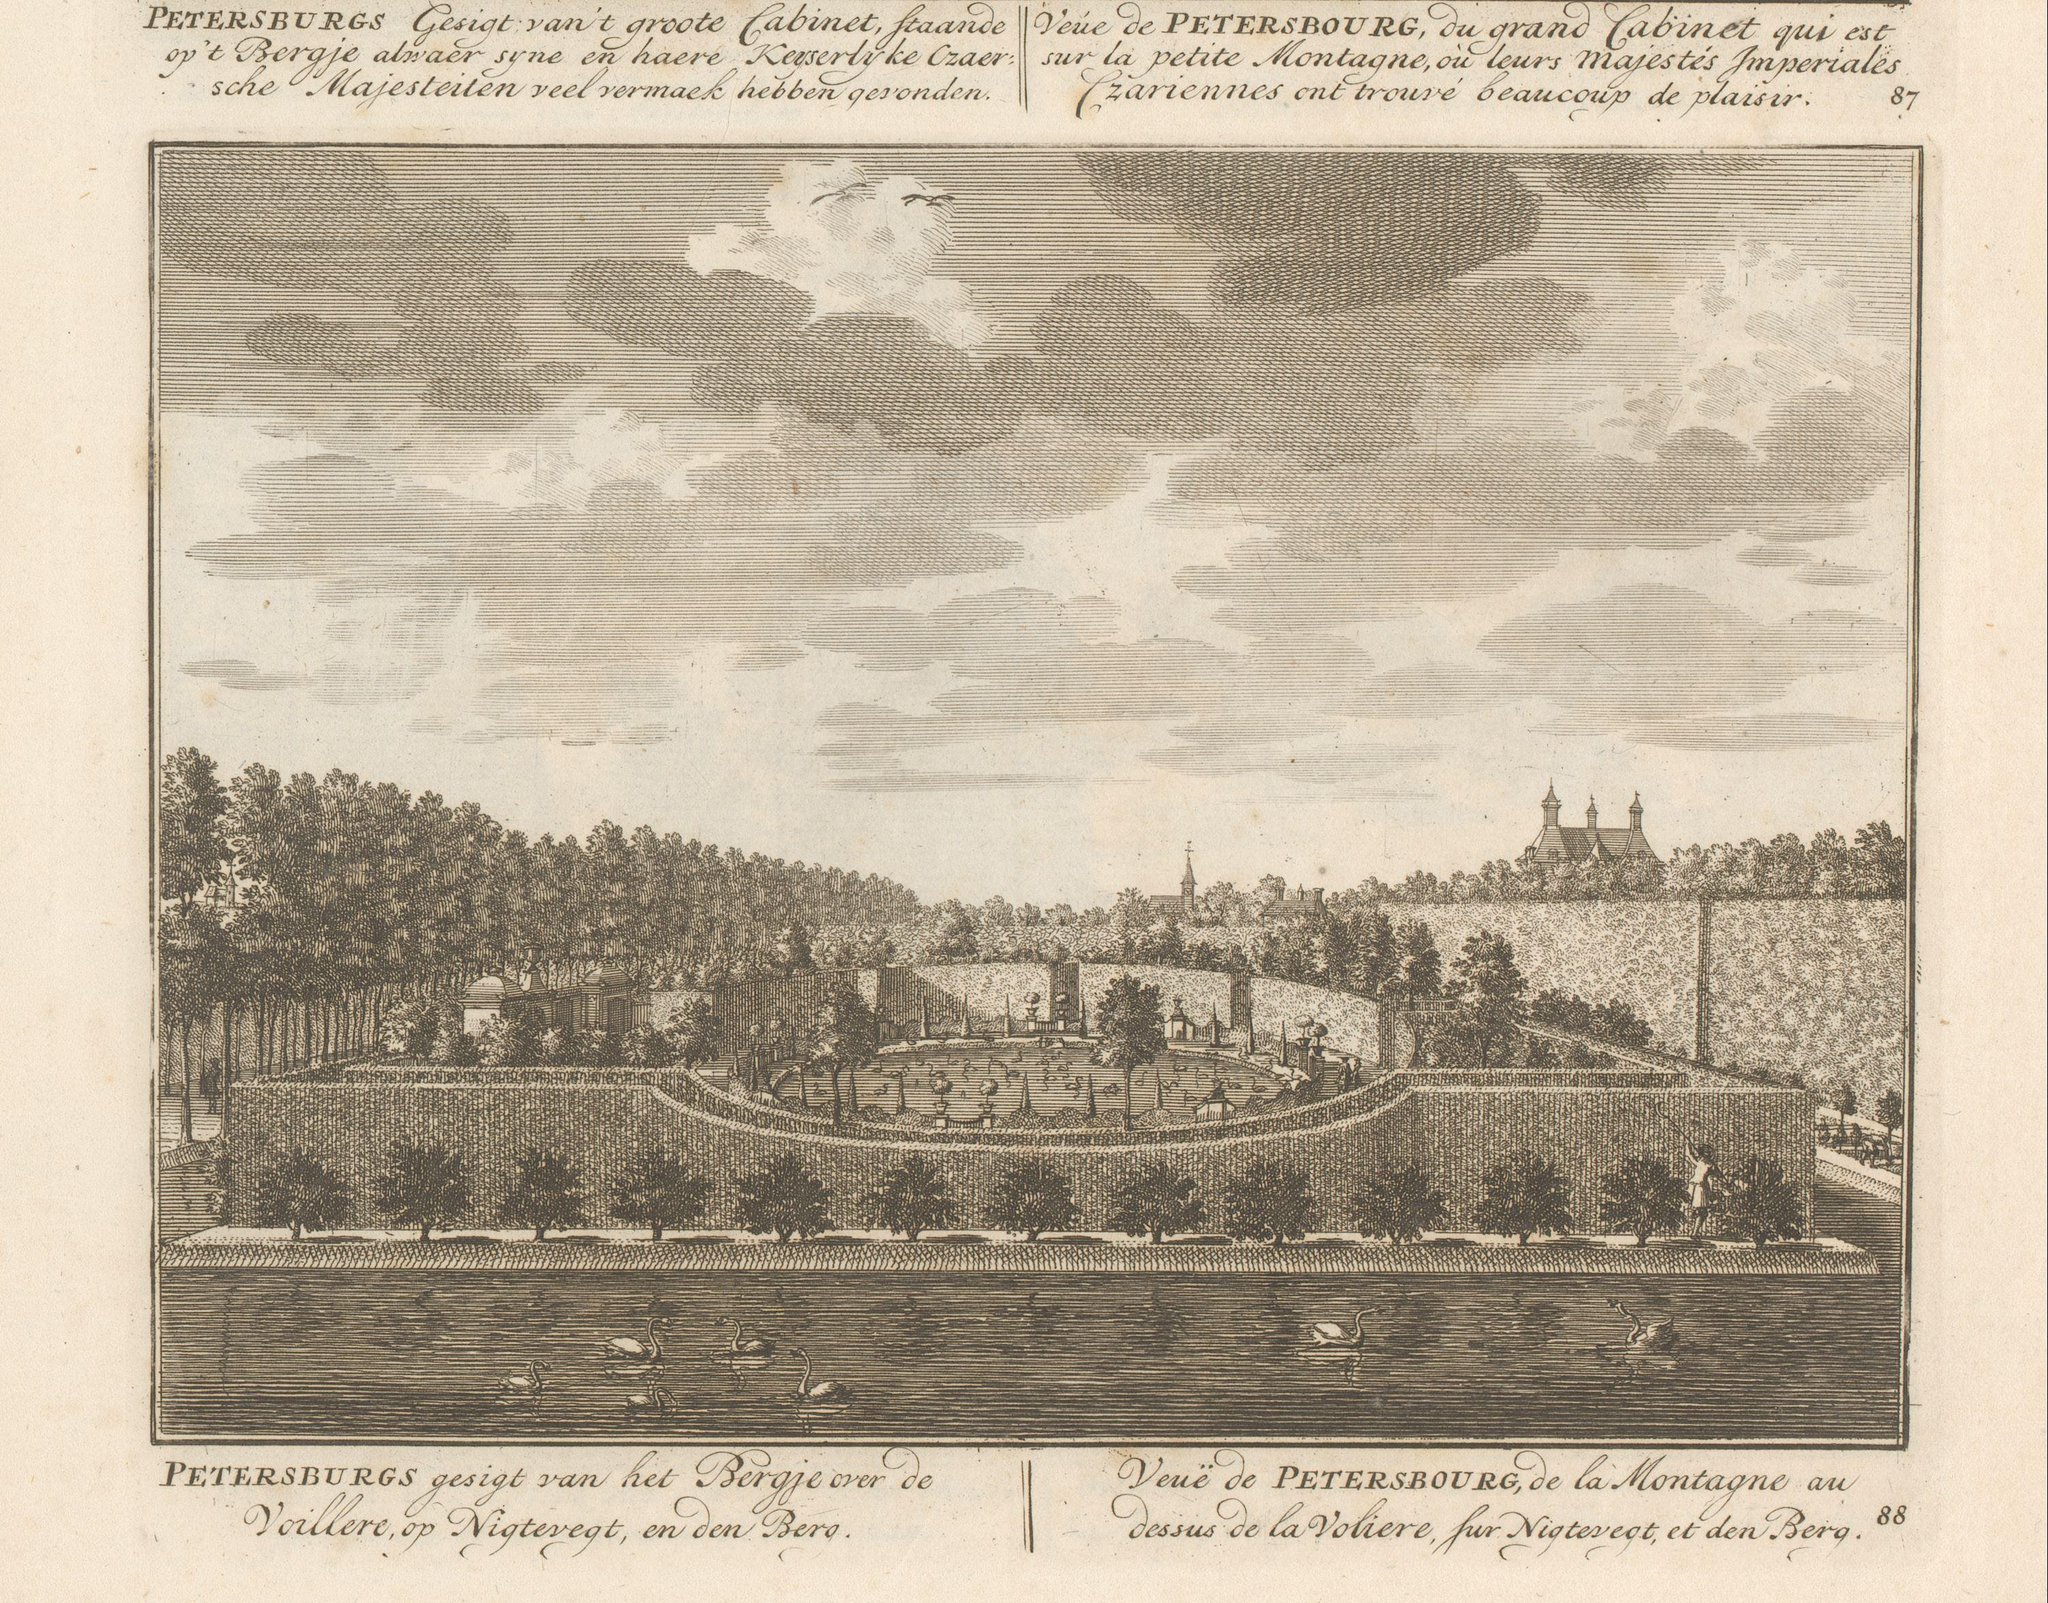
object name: book illustration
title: Gezicht op de tuin met volière van de buitenplaats Petersburg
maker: daniël stopendaal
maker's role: print maker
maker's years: 1672-1726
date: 1790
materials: paper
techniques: engraving, etching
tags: birds in a large cage, aviary, belvedere, nederhorst den berg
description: Prent gebruikt in: Leth, Andries de. De zegepraalende Vecht, vertoonende verscheidene gesichten van lustplaatsen, heeren huysen en dorpen, beginnende van Uitrecht en met Muyden besluytende (...). Amsterdam: Weduwe Nicolaus Visscher, 1719. Prent ook gebruikt in: Brouërius van Nidek, Matthaeus. De Vechtstroom, van Utrecht tot Muiden (...). Amsterdam: H. Gartman, W. Vermandel en J.W. Smit, 1790.